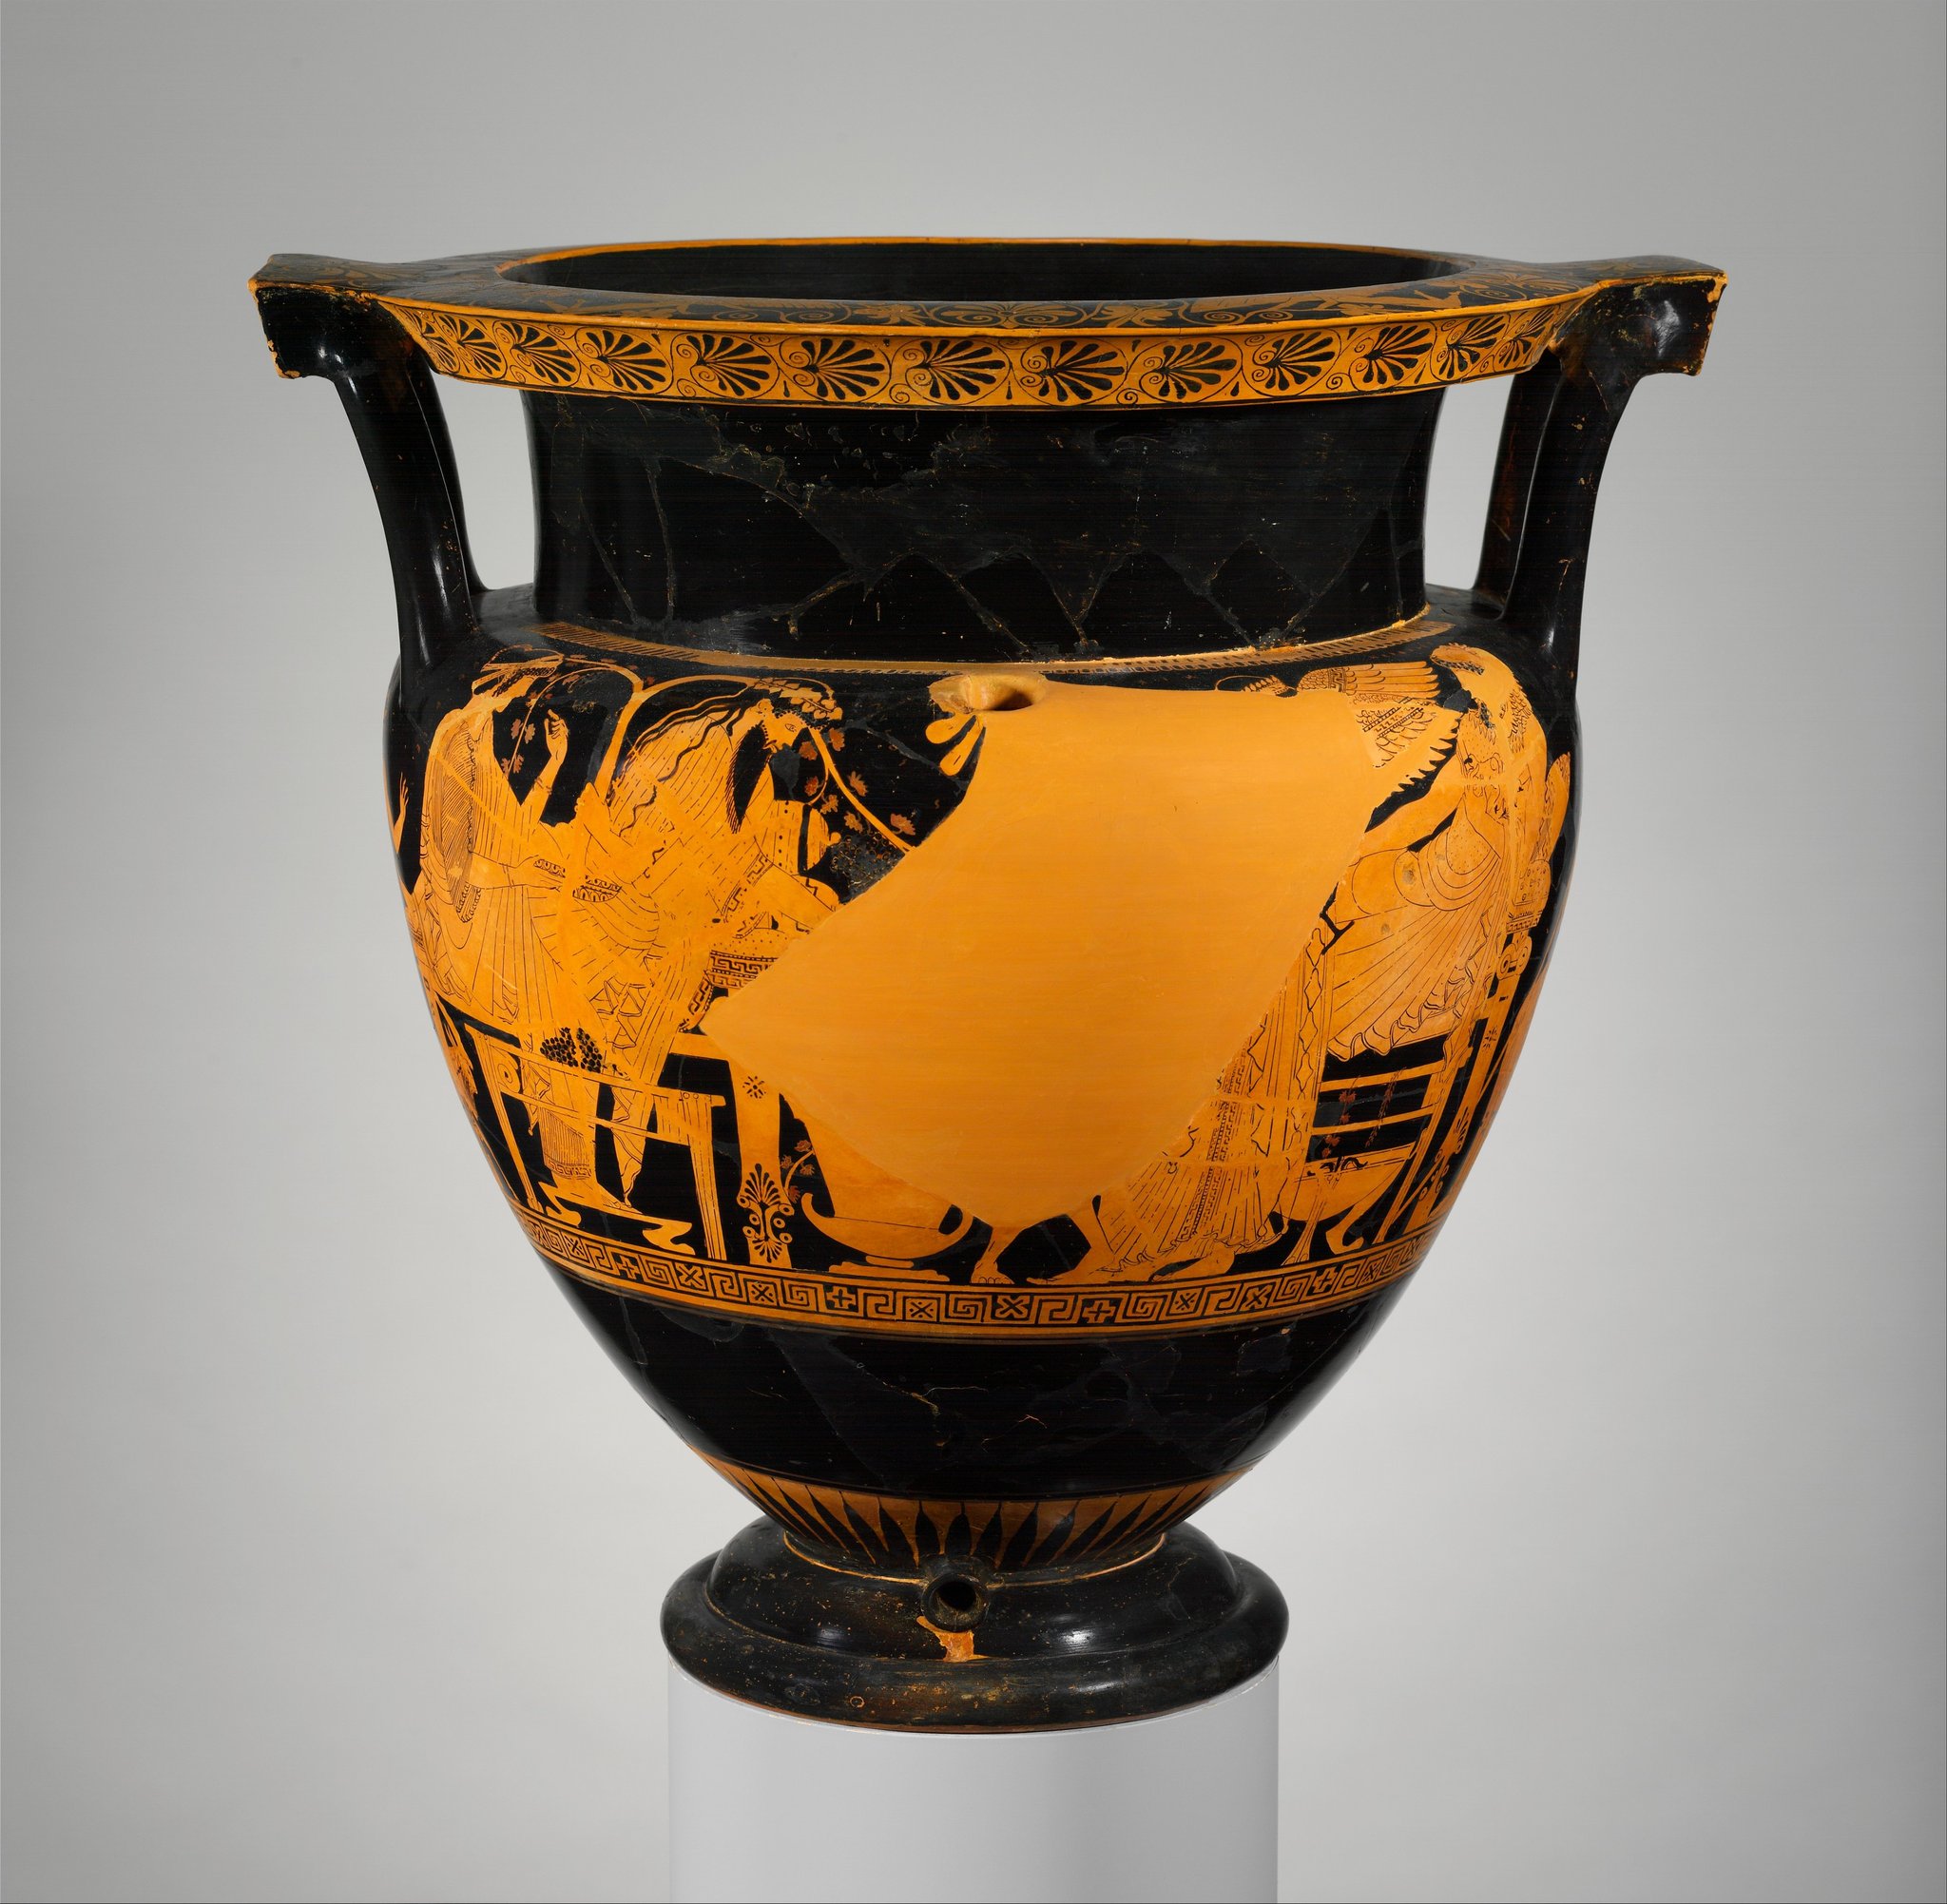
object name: column krater with built in psykter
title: Terracotta psykter-column-krater (vase for chilling and mixing wine and water)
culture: greek, attic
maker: troilos painter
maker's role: artist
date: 480-470 BCE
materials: terracotta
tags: dionysus,herakles